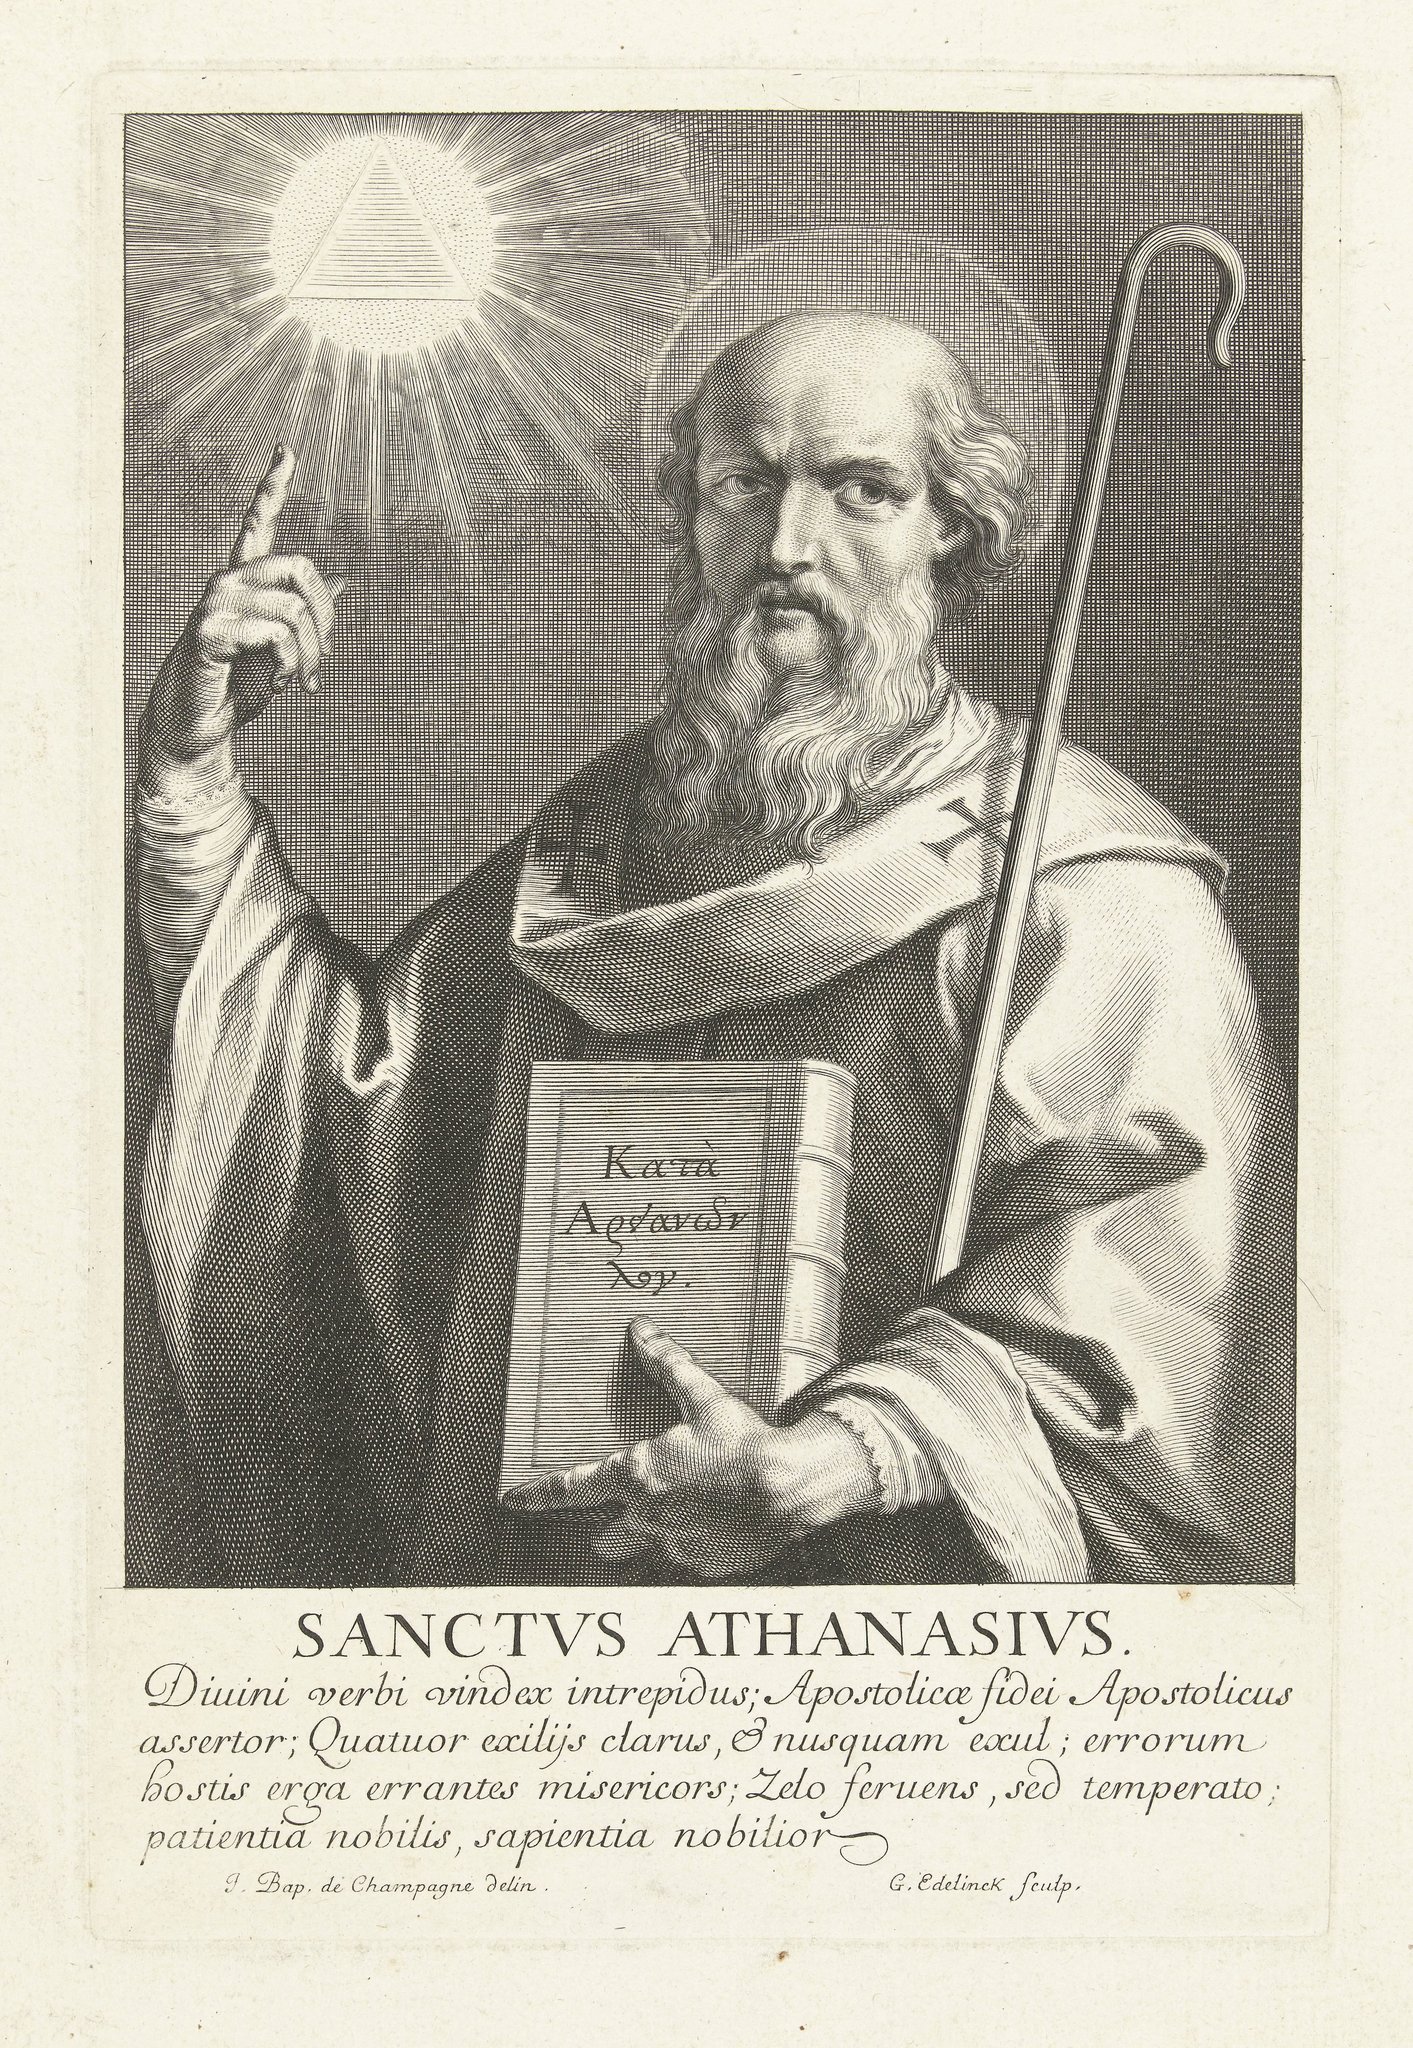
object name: print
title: Heilige Athanasius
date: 1666-1707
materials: paper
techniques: engraving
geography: paris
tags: athanasius the great, bishop of alexandria; possible attributes: book, heretic under feet, scroll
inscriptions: collector's mark: Lugt 240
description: De heilige Athanasius met boek en staf, wijst omhoog naar de heilige drie-eenheid, weergegeven als een gelijkzijdige driehoek in een lichtkrans. Onder de voorstelling een onderschrift in Latijn.